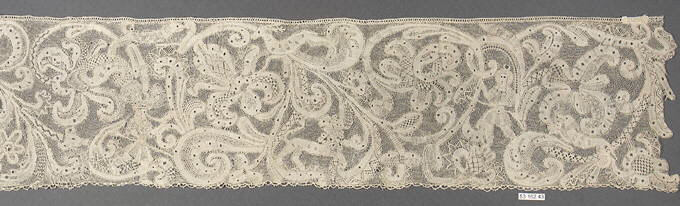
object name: insertion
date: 1601-1800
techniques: lace